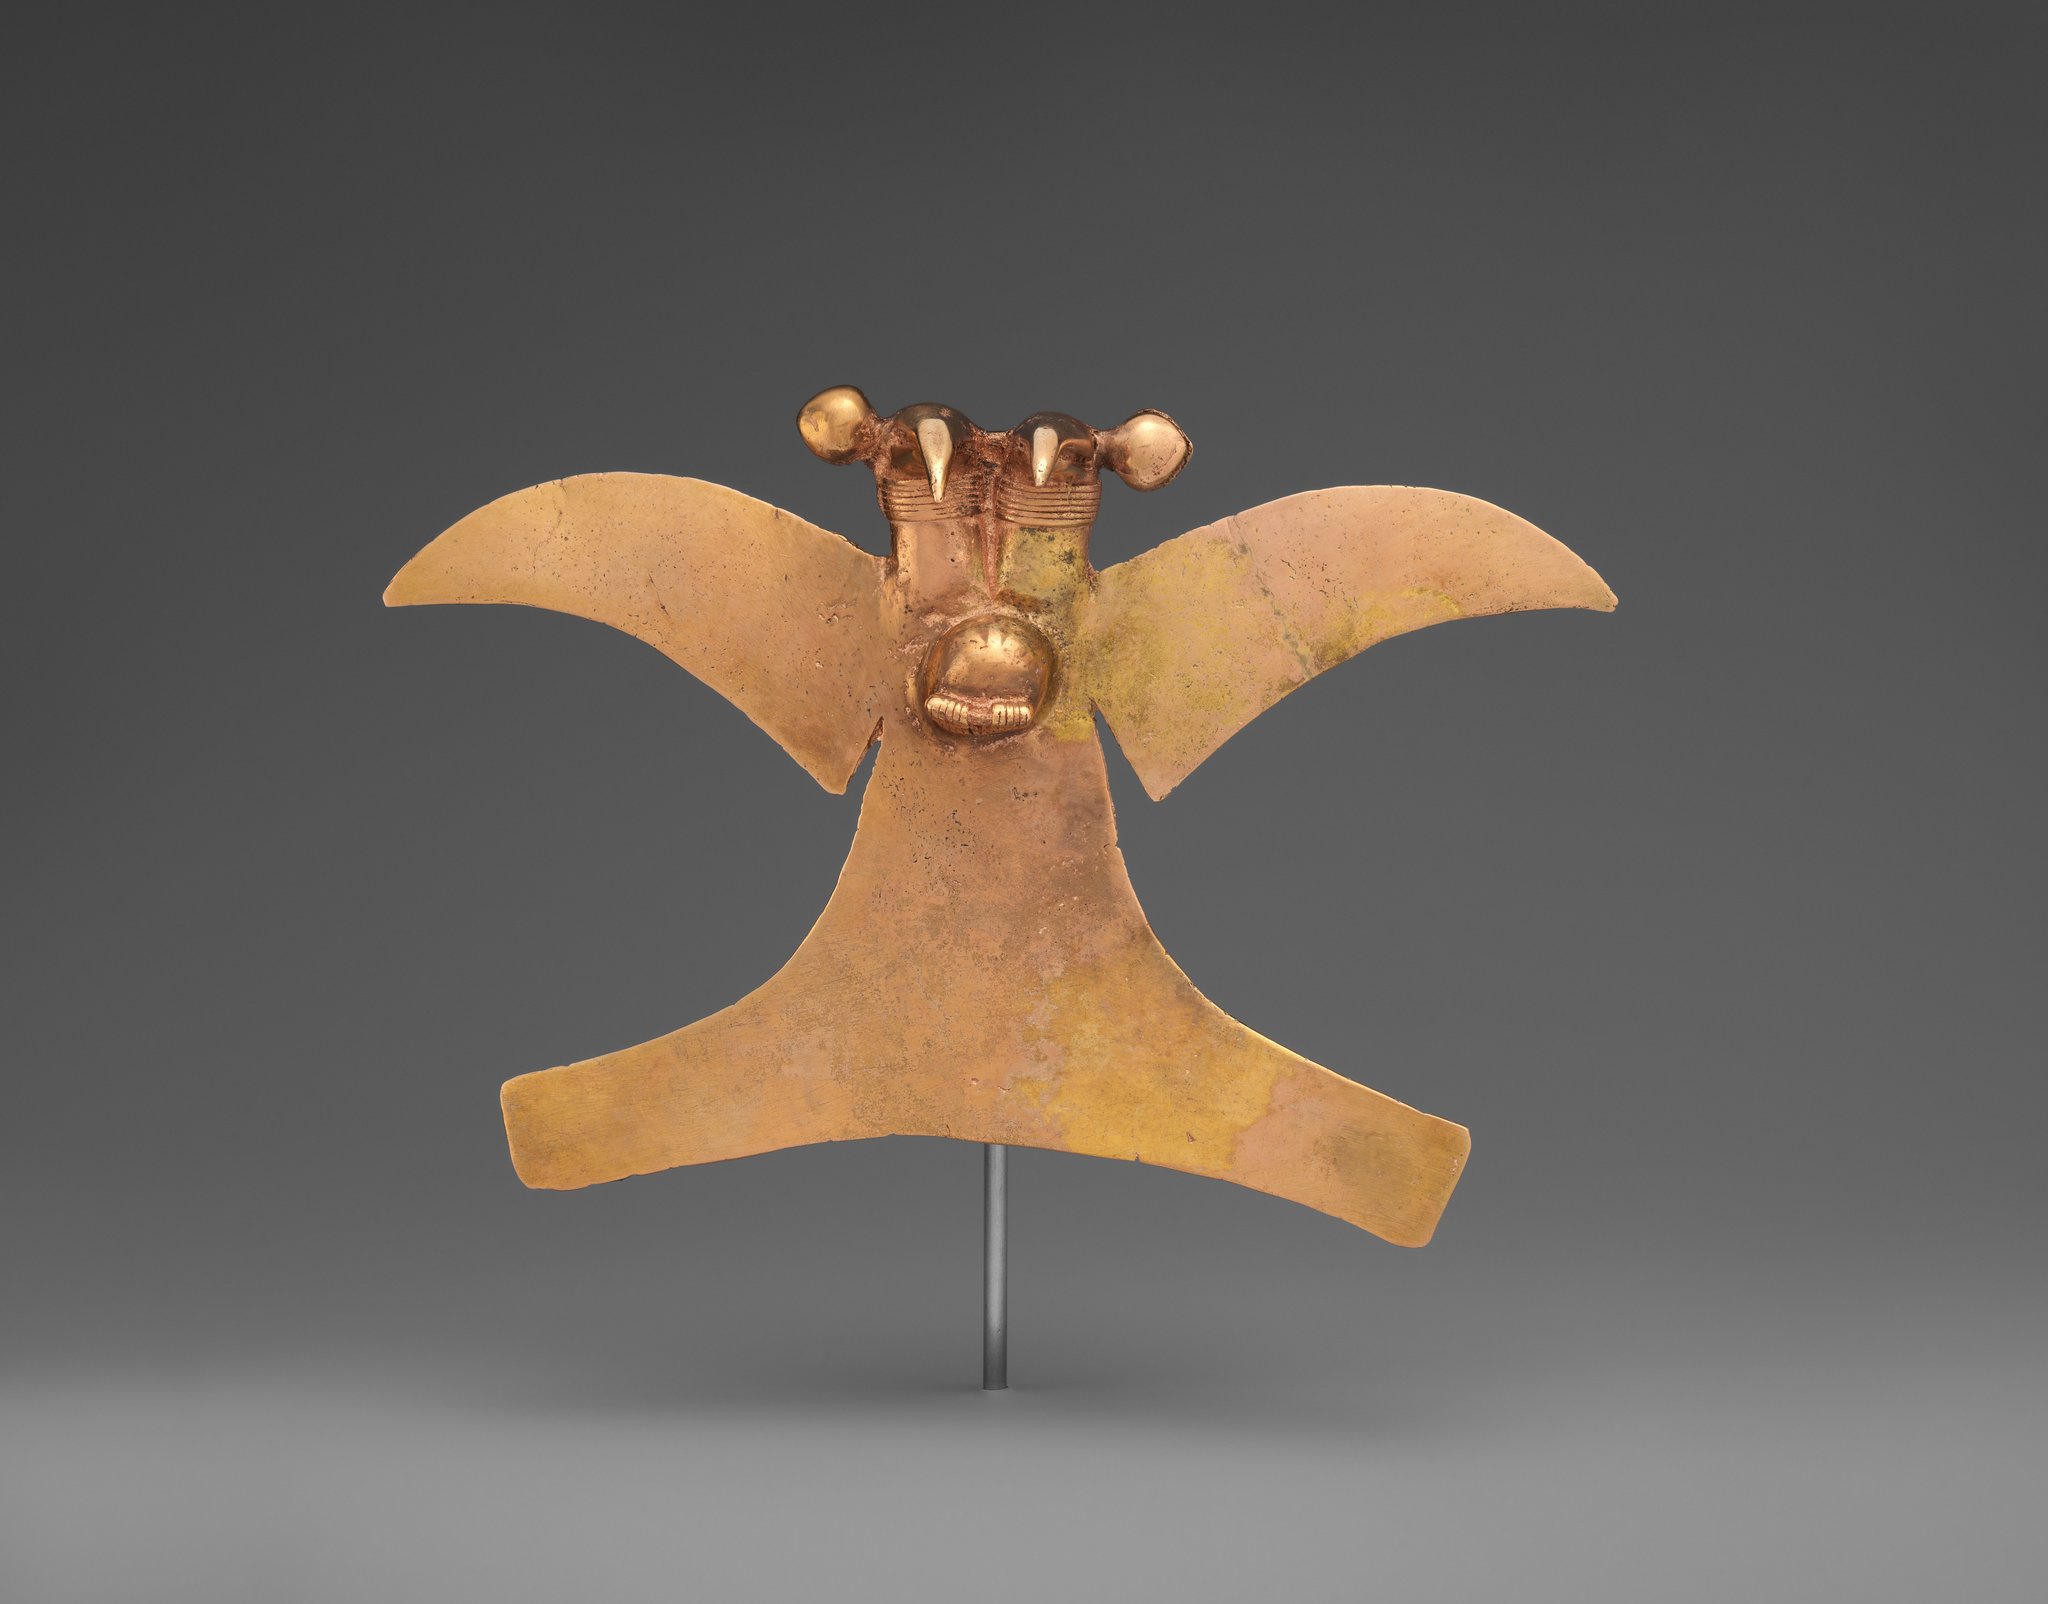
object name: pendant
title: Double Eagle Pendant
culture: veraguas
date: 1001-1600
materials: gold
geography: panama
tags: eagles